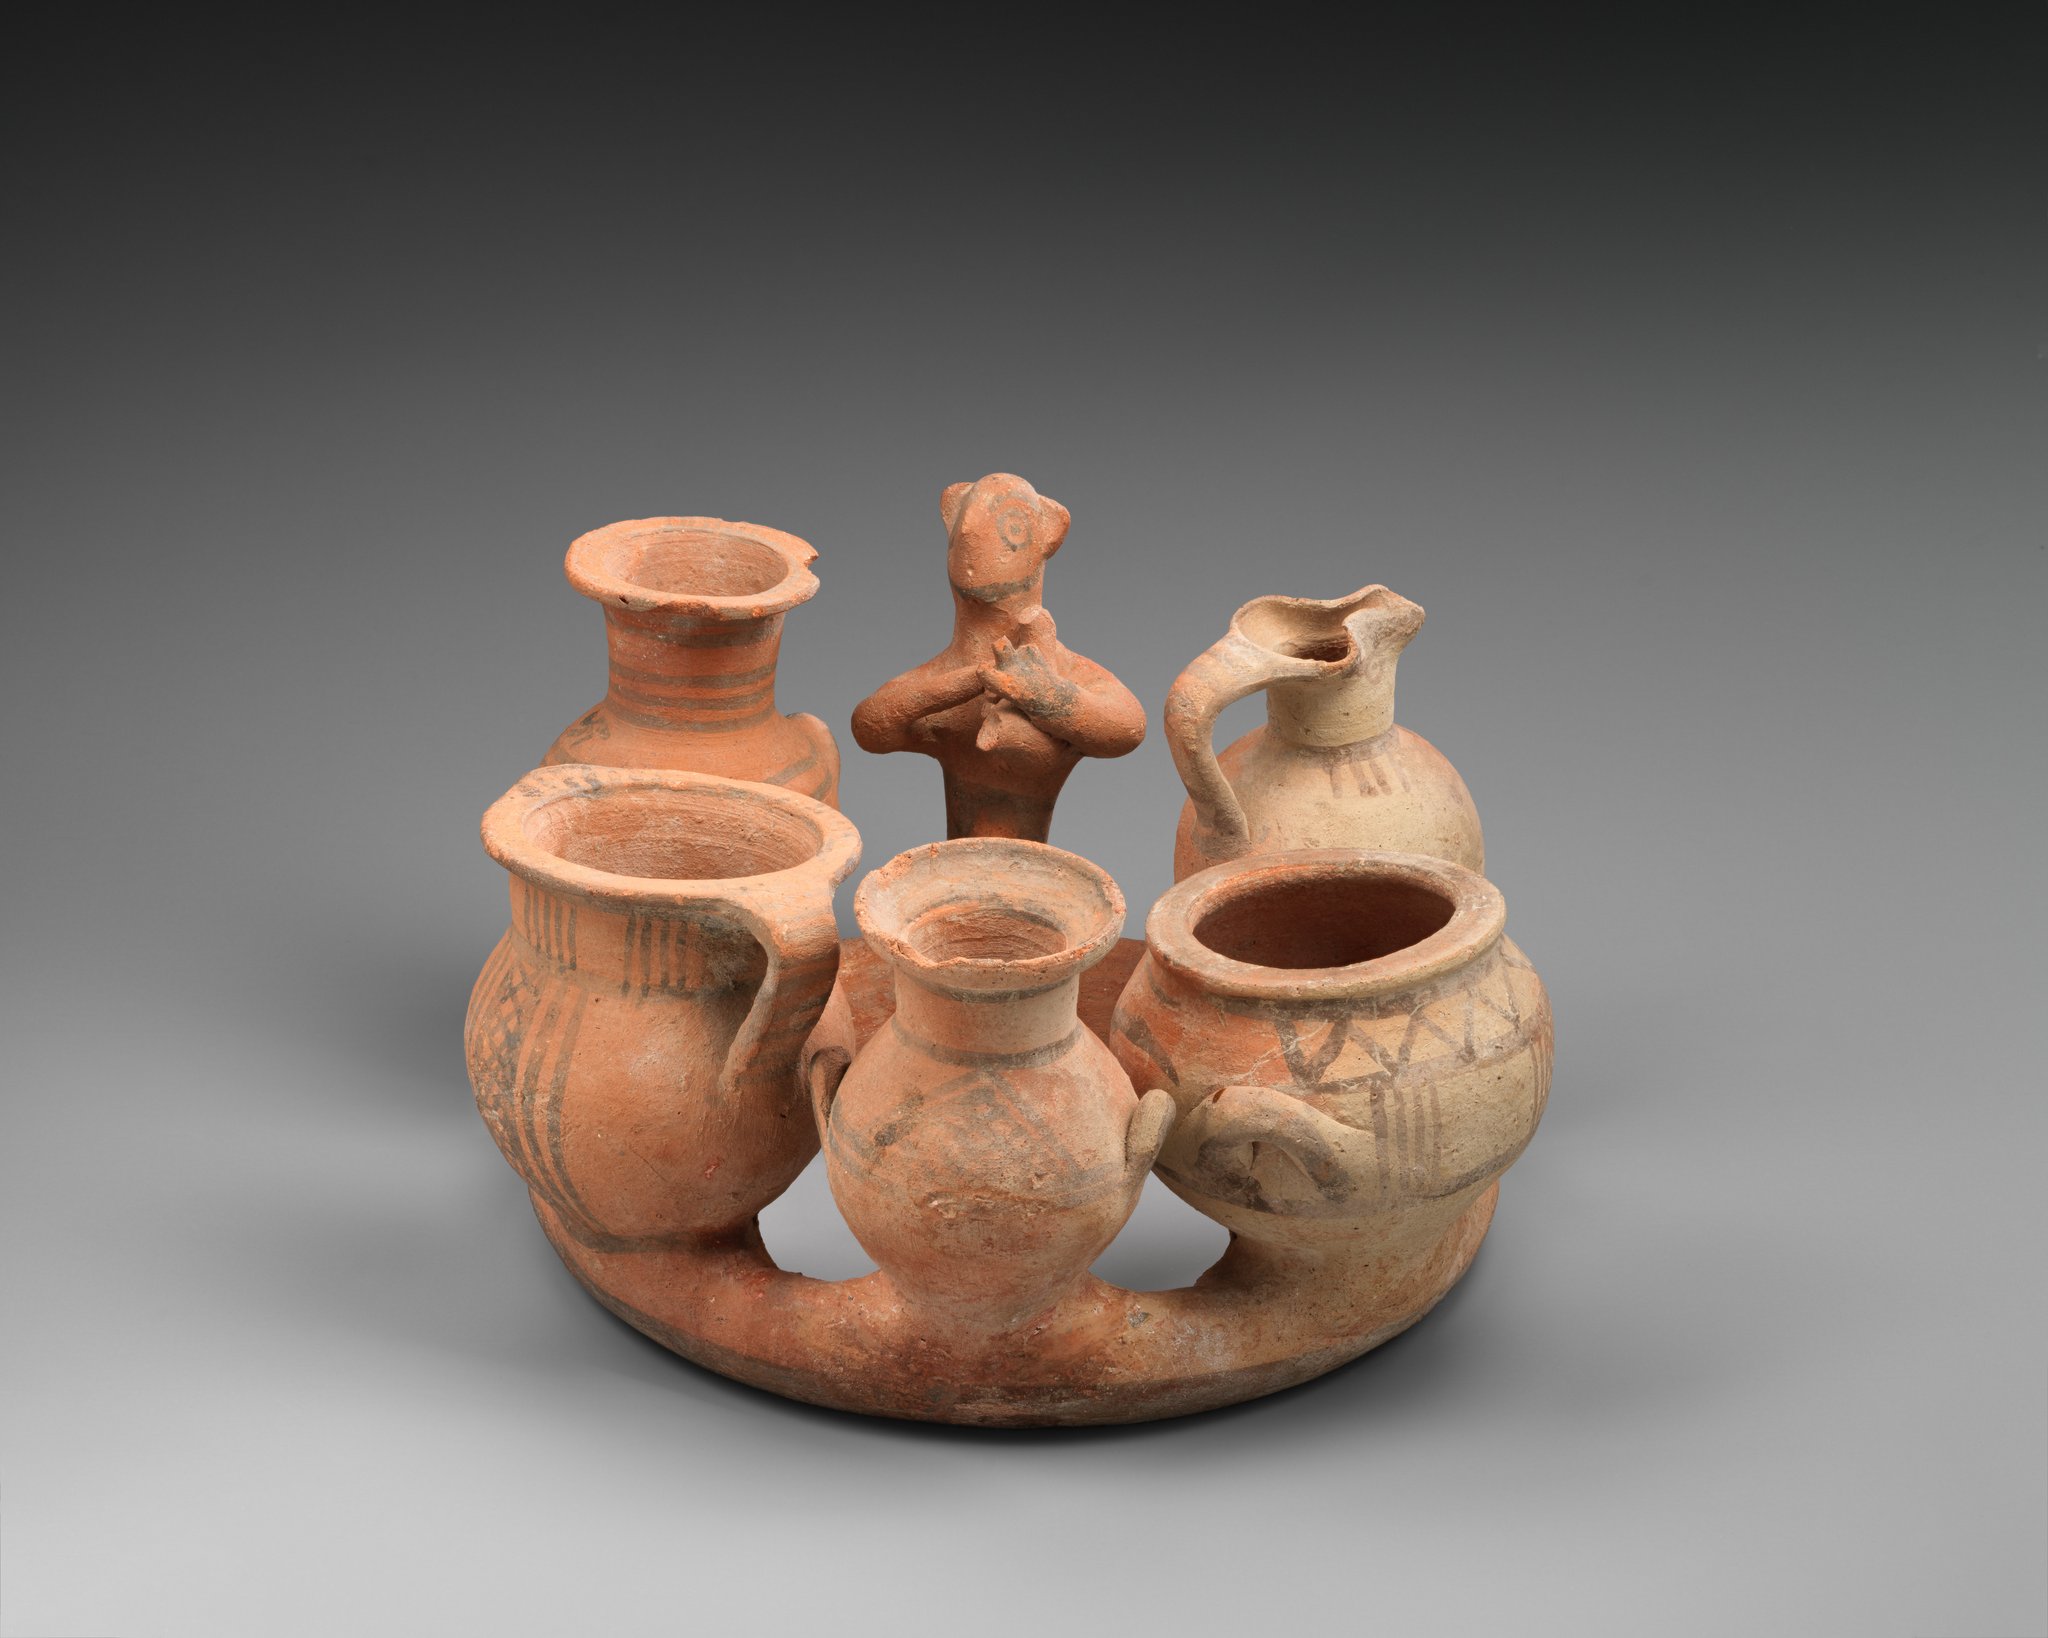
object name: ring kernos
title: Terracotta ring-kernos (offering vase)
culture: cypriot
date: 850-750 BCE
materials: terracotta